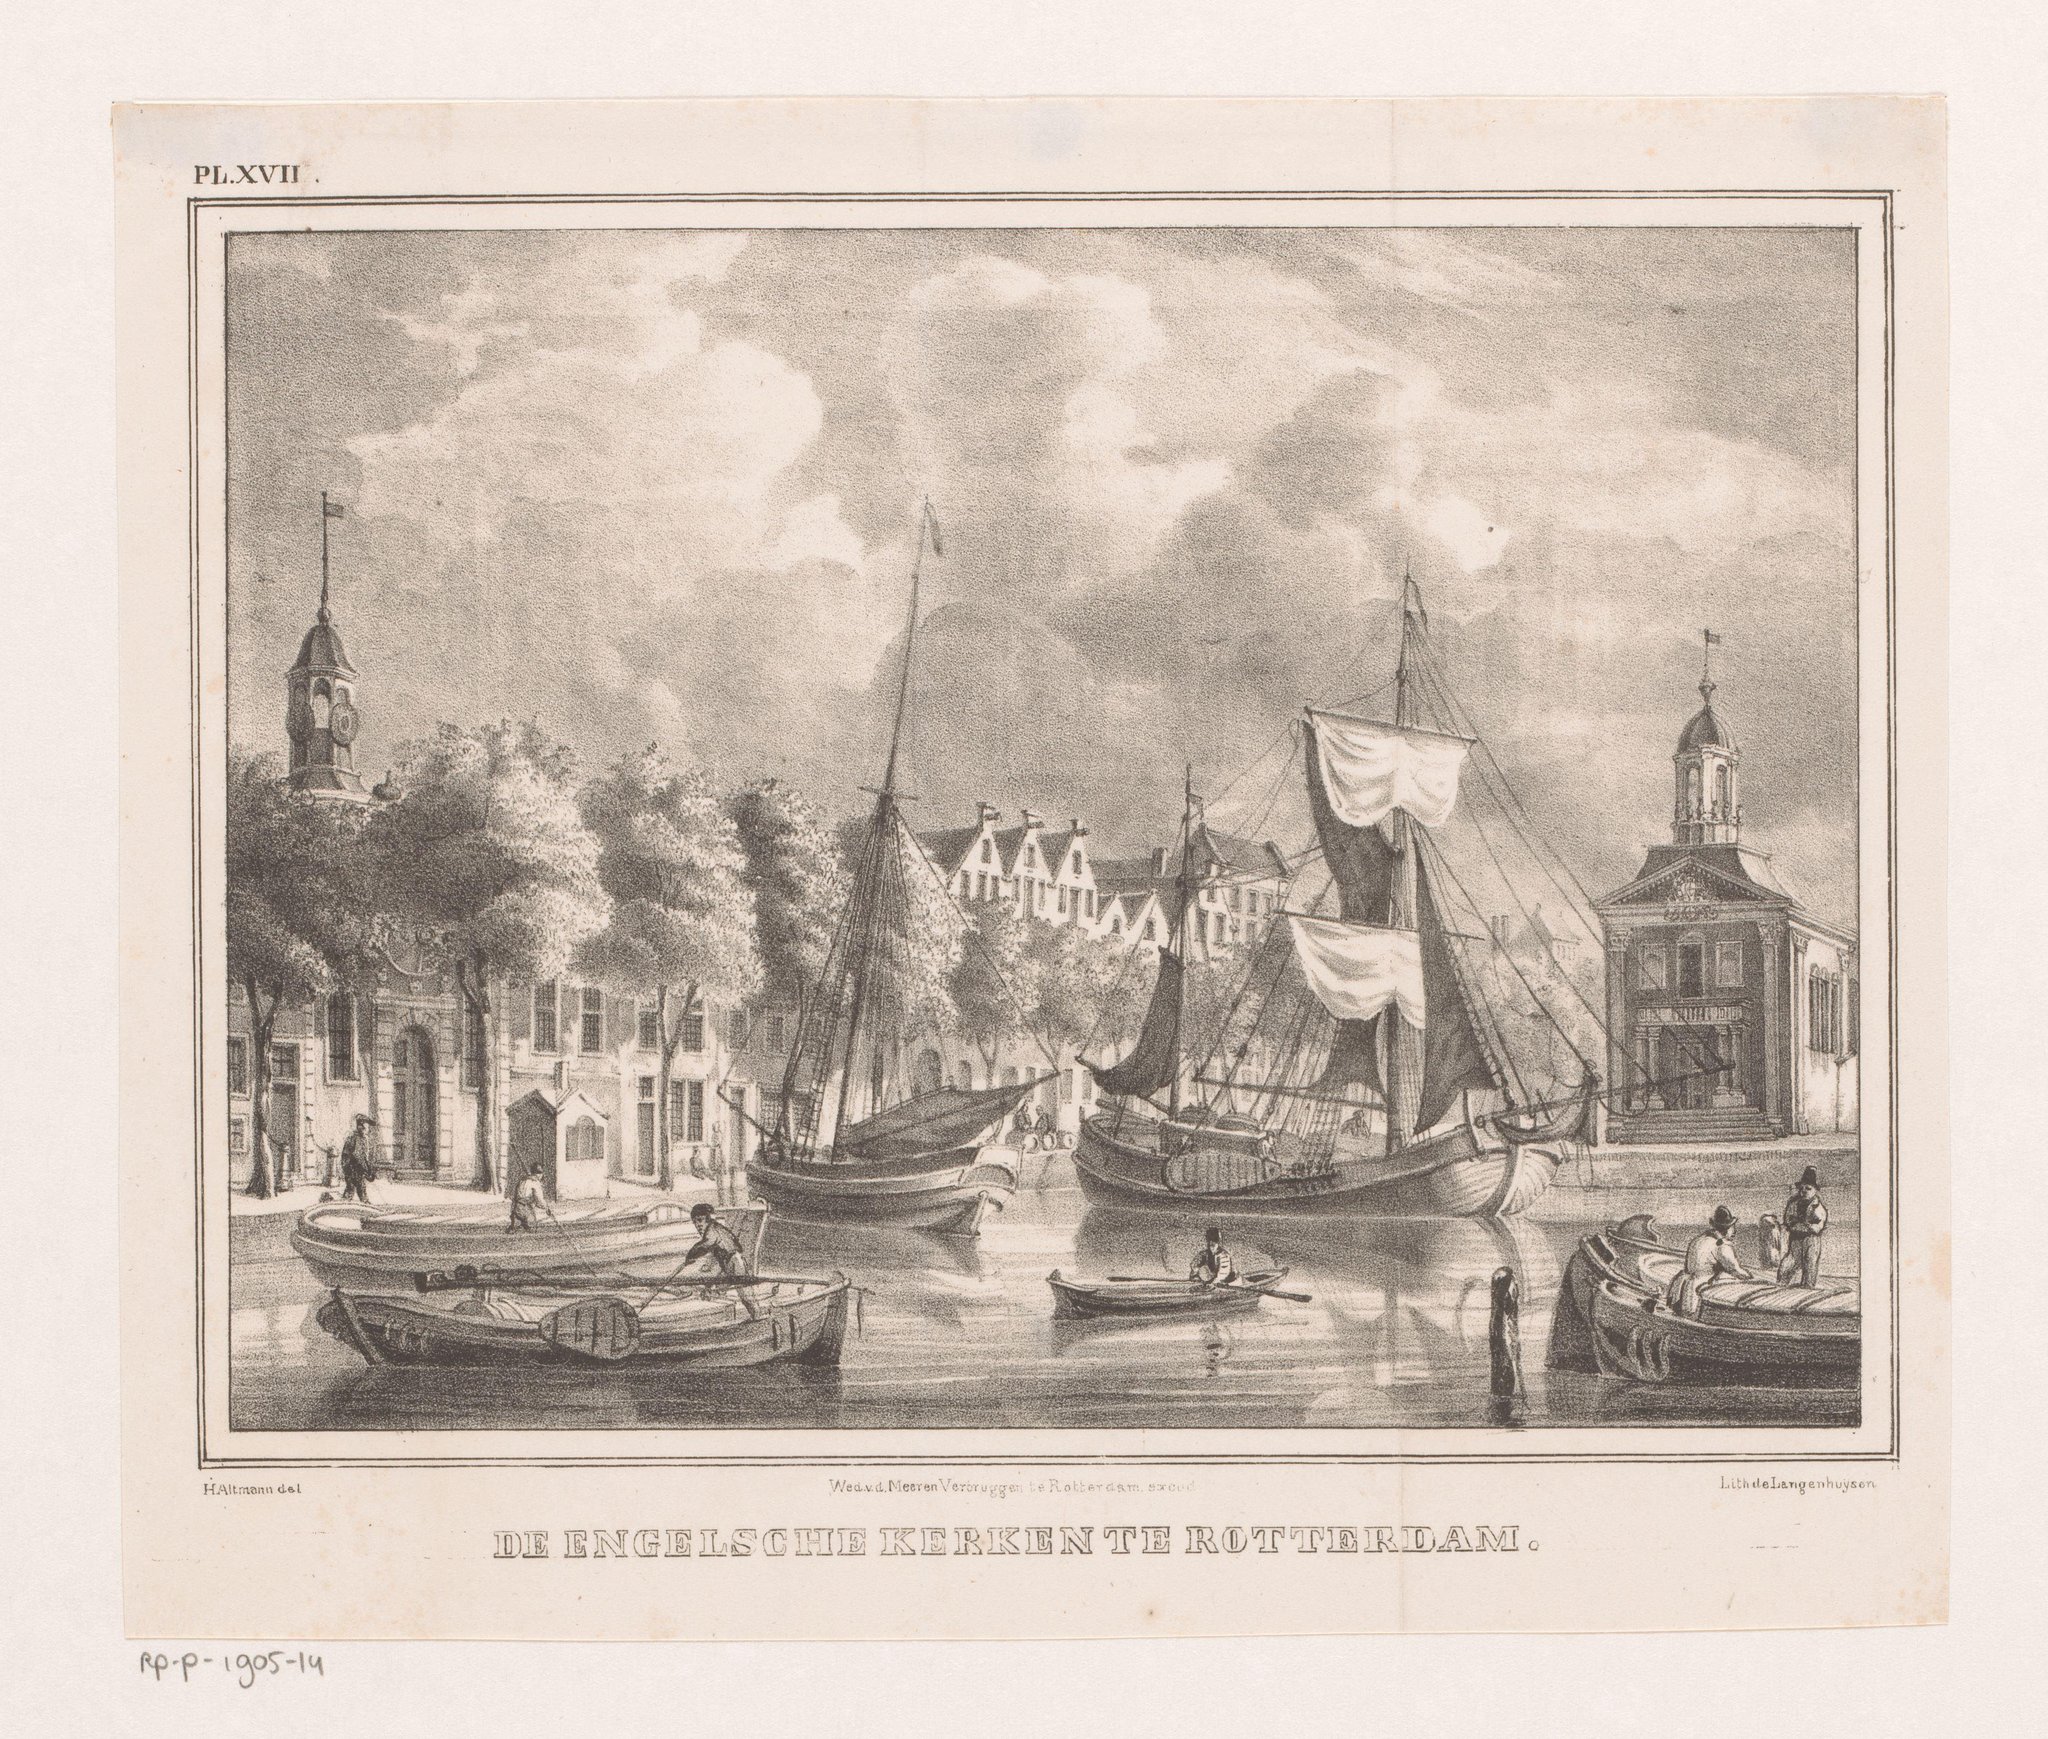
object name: print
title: Boten op het water voor de St. Mary's Church in Rotterdam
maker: hendrik altmann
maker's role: draughtsman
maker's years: 1791-1863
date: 1830-1863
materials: paper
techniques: lithograph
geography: rotterdam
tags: ships (in general), church (exterior), canals, waters (in city)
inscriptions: collector's mark: Lugt 2228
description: Mogelijk werd deze prent uitgegeven in: Reyn, G. van Geschiedkundige beschrijving der stad Rotterdam; en beknopt overzicht van het hoogheemraadschap van Schieland. Rotterdam: Wed. van der Meer & Verbruggen, 1832.